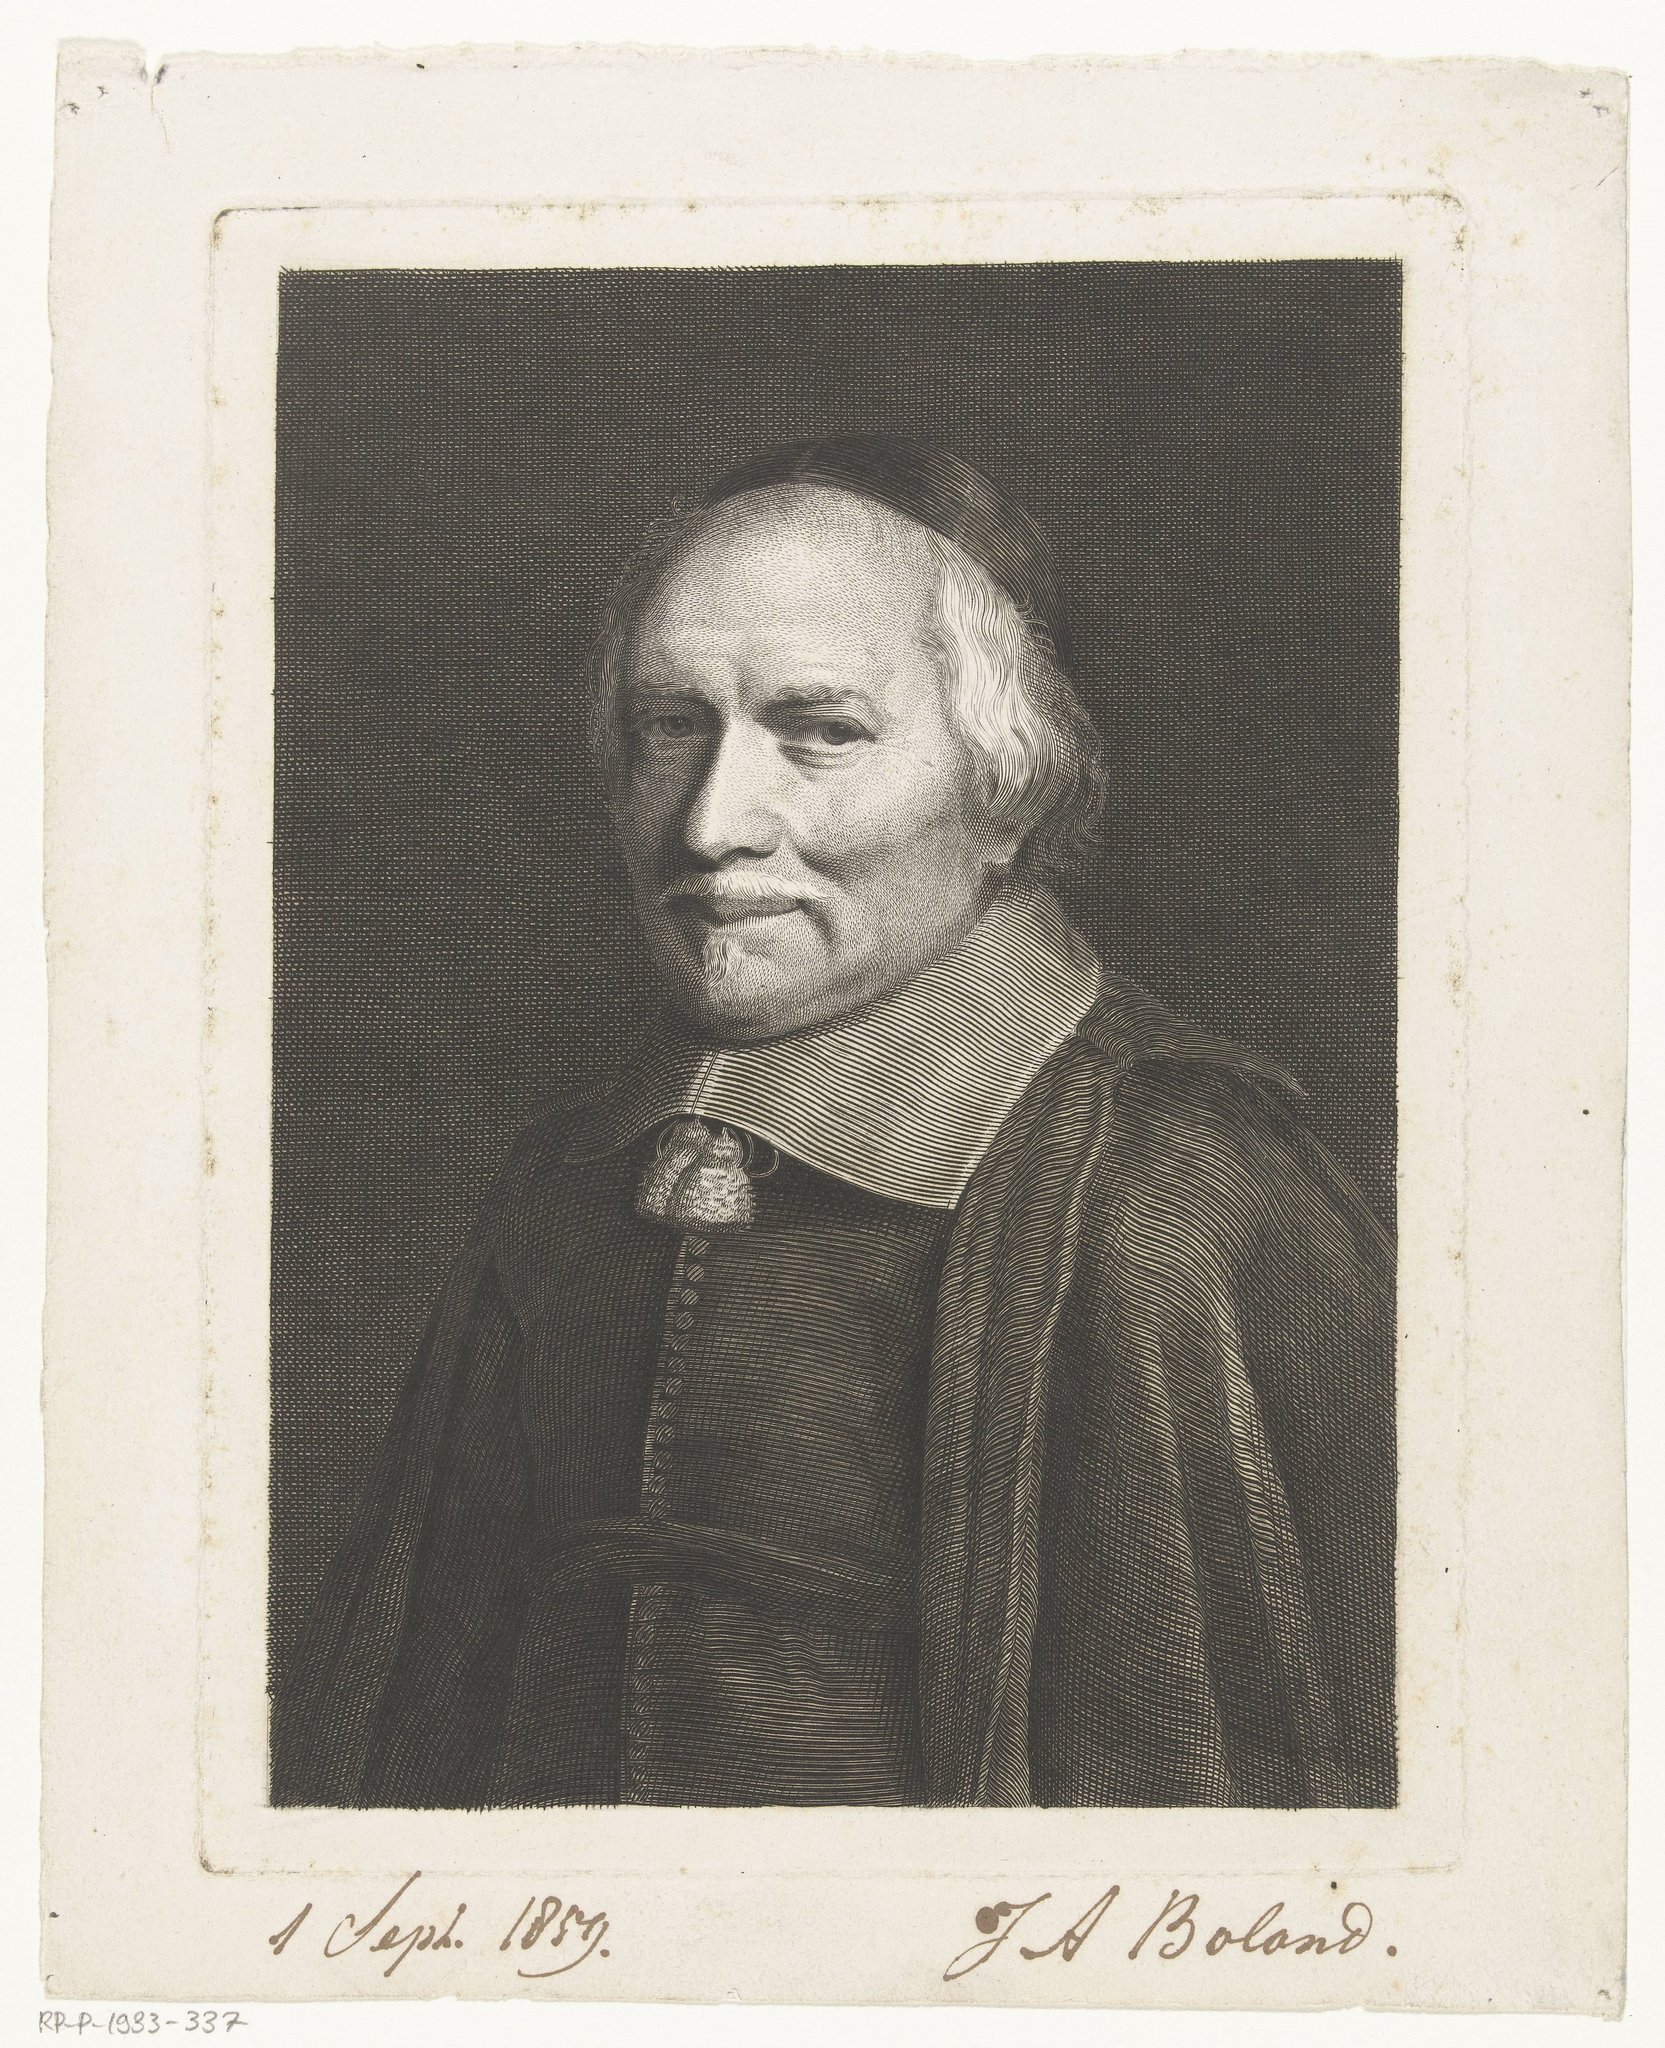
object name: print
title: Portret van Jacob Cats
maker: johannes arnoldus boland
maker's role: print maker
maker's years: 1838-1922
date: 1889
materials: paper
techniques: engraving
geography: amsterdam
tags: jacob cats (1577-1660)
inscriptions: date: ‘1 sept. 1889.’, signature: ‘JA Boland’